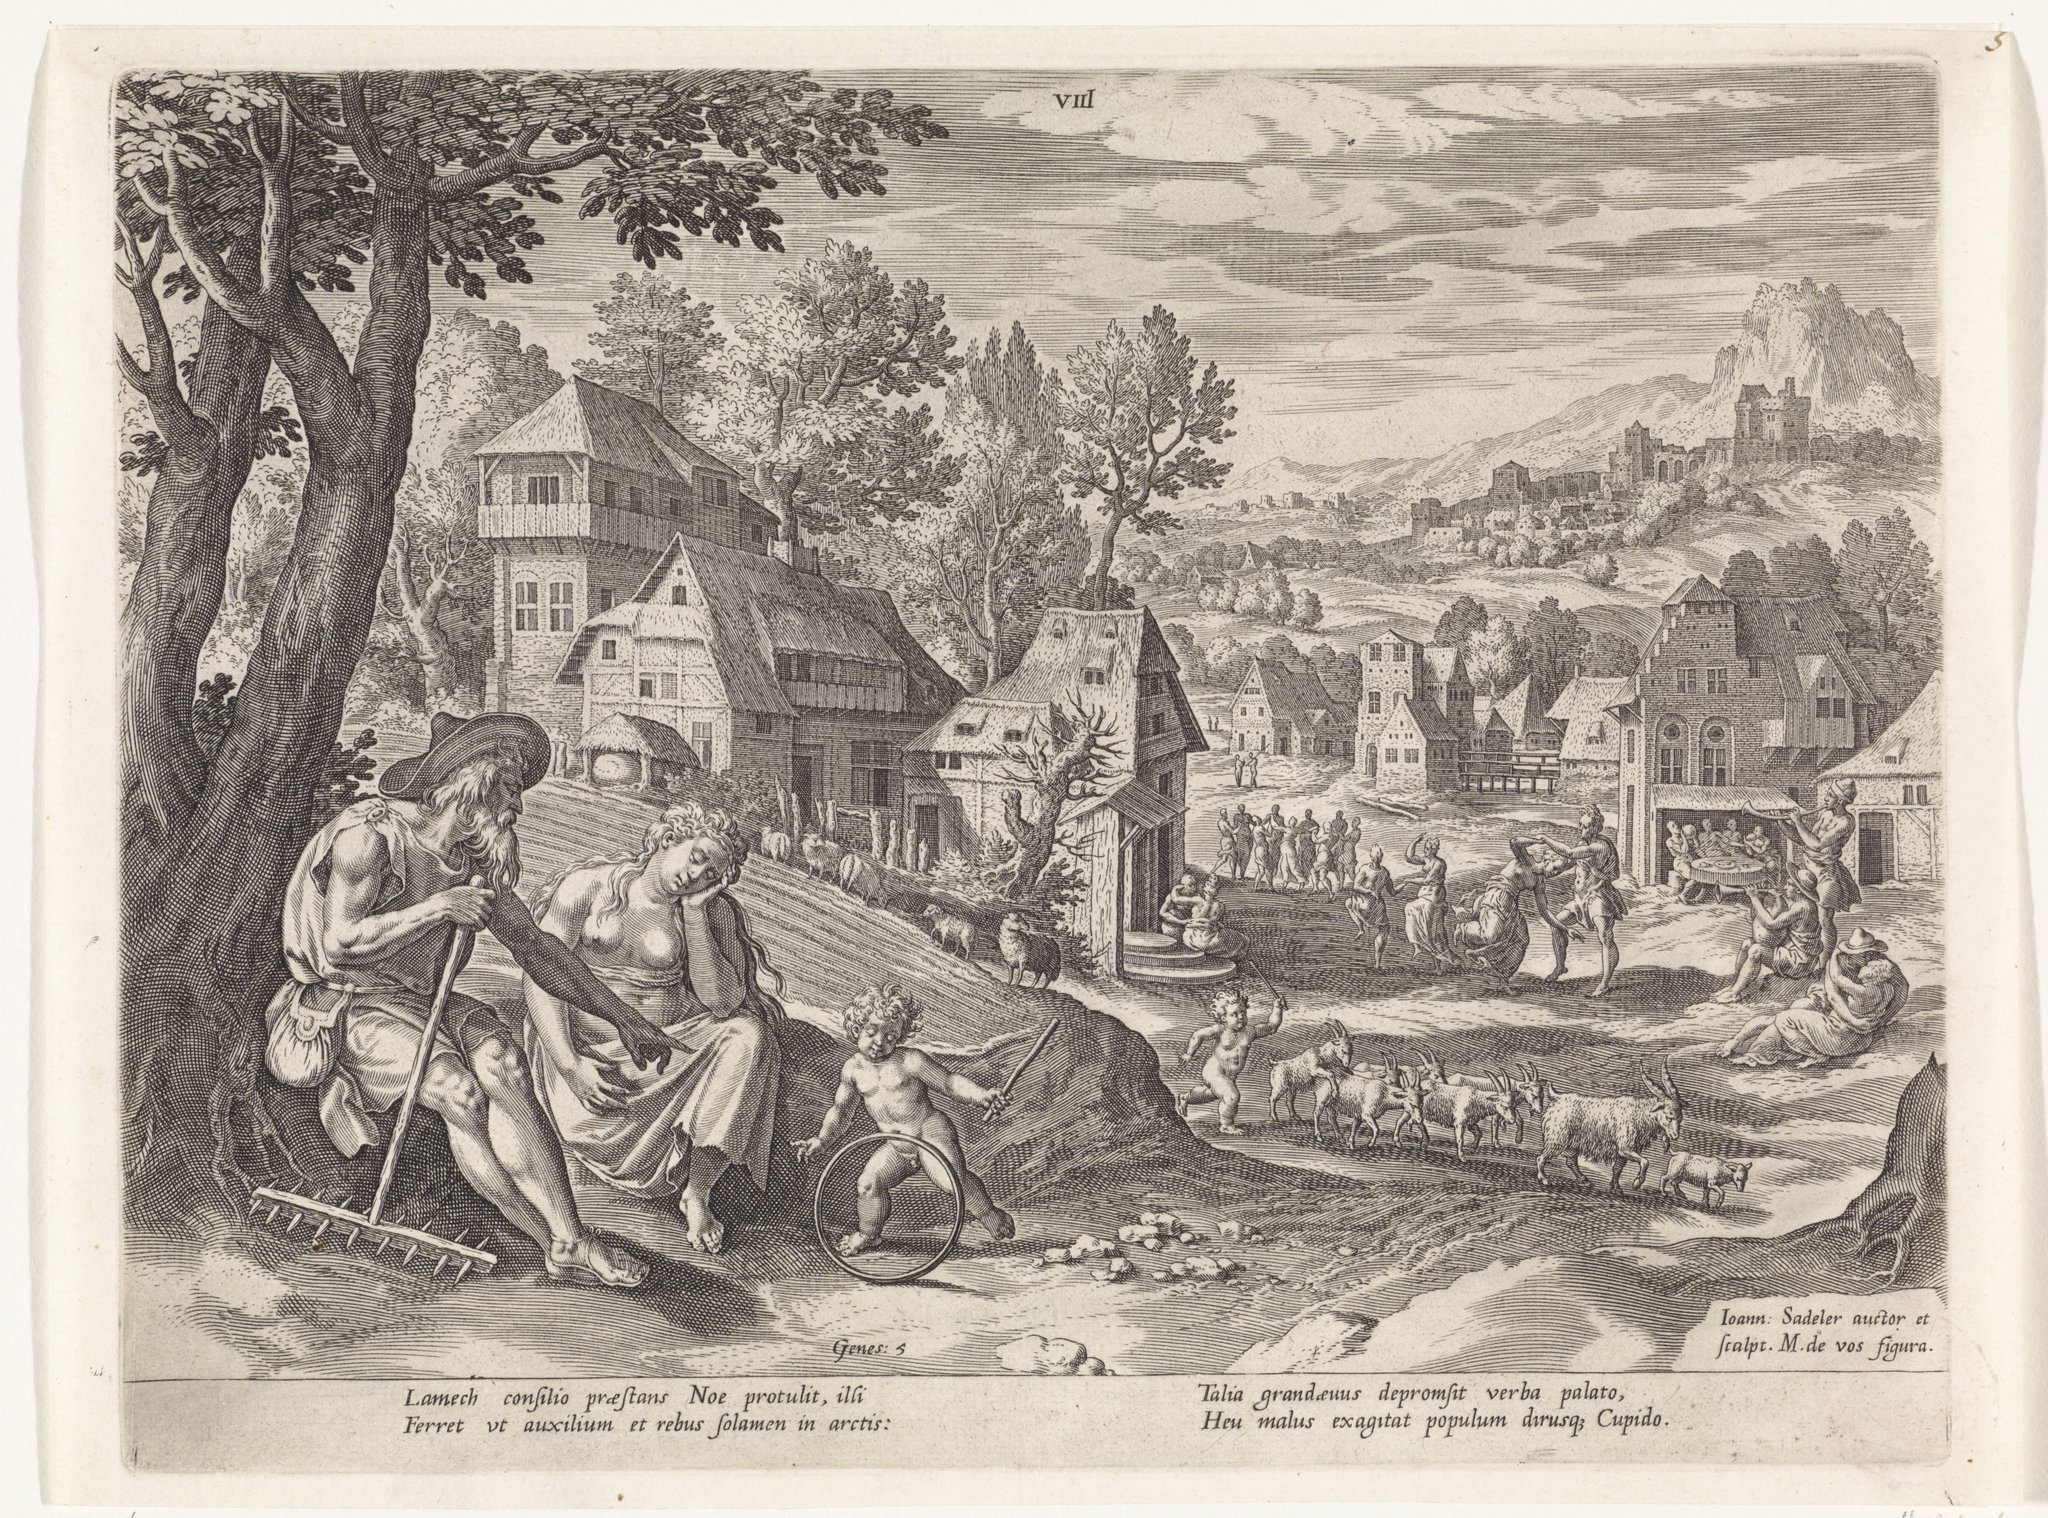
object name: print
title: Geschiedenis van de familie van Set / Over het goed en het slecht oordelen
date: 1586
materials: paper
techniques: engraving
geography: antwerp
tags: story of lamech, son of methuselah, village, public festivities, the wickedness of mankind; the wicked are usually shown feasting and revelling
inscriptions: collector's mark: Lugt 240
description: Lamech zit met een hark onder een boom. Naast hem slaapt zijn vrouw en speelt de jonge Noach met een hoepel. Op de achtergrond een dorpsfeest met dansende en musicerende mannen en vrouwen. De prent heeft een Latijns onderschrift.